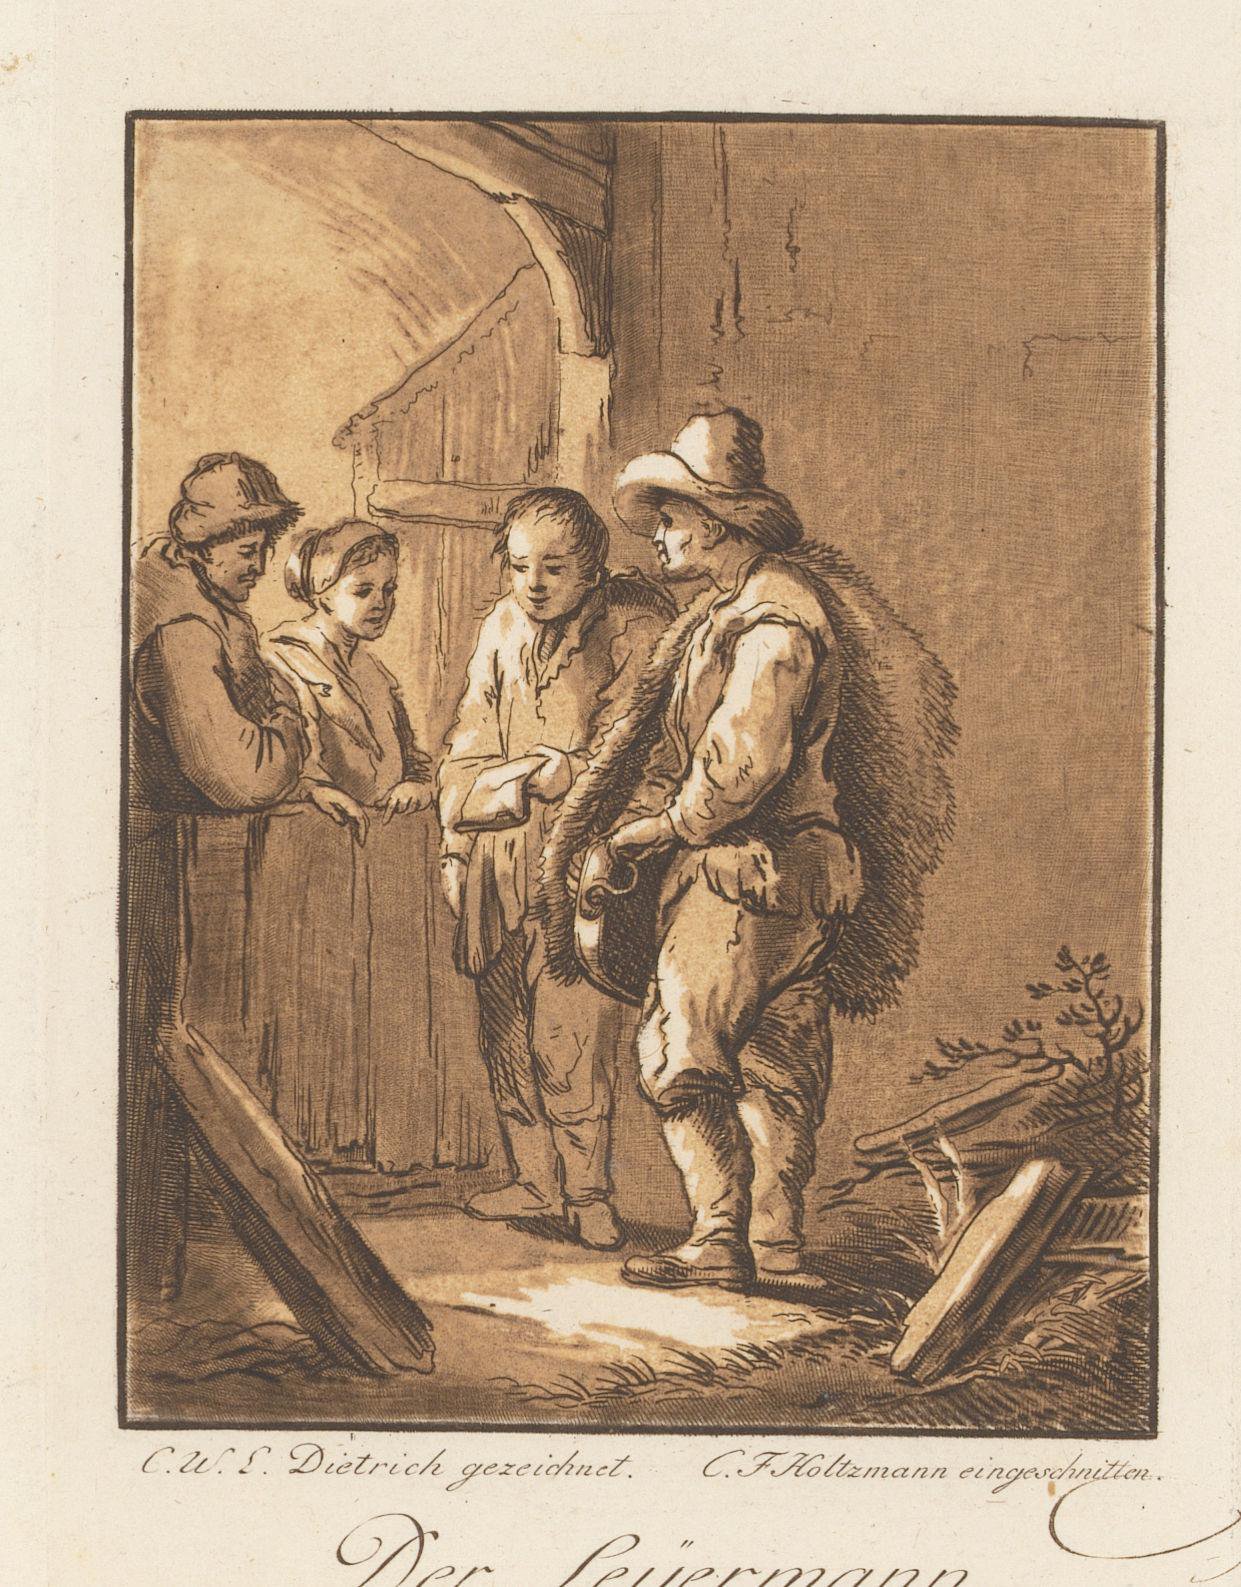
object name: print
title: Der Leijermann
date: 1750-1811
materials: paper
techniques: drypoint, etching, intaglio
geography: dresden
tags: reading to somebody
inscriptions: collector's mark: Lugt 2228, collector's mark: Lugt 2760, annotation